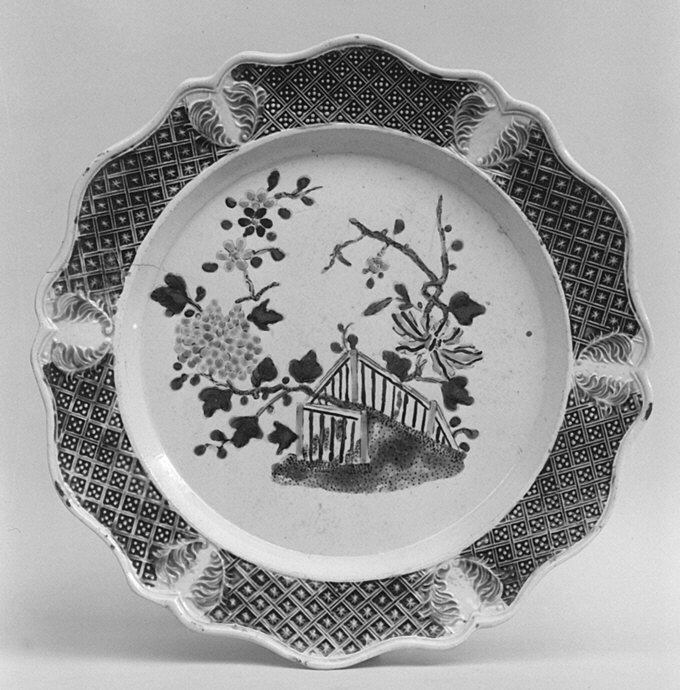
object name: plate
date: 1760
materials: stoneware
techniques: salt glaze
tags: flowers